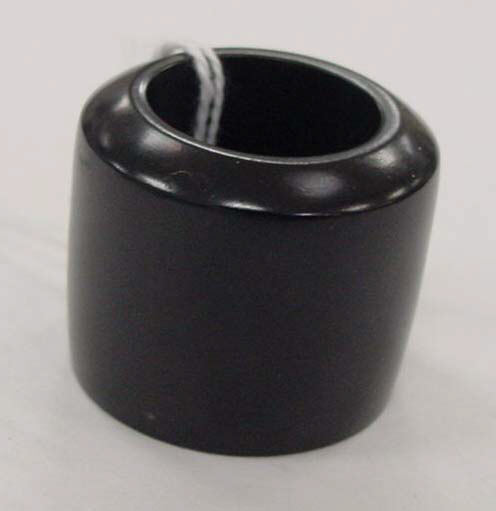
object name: ring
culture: chinese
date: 1801-1900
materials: onyx